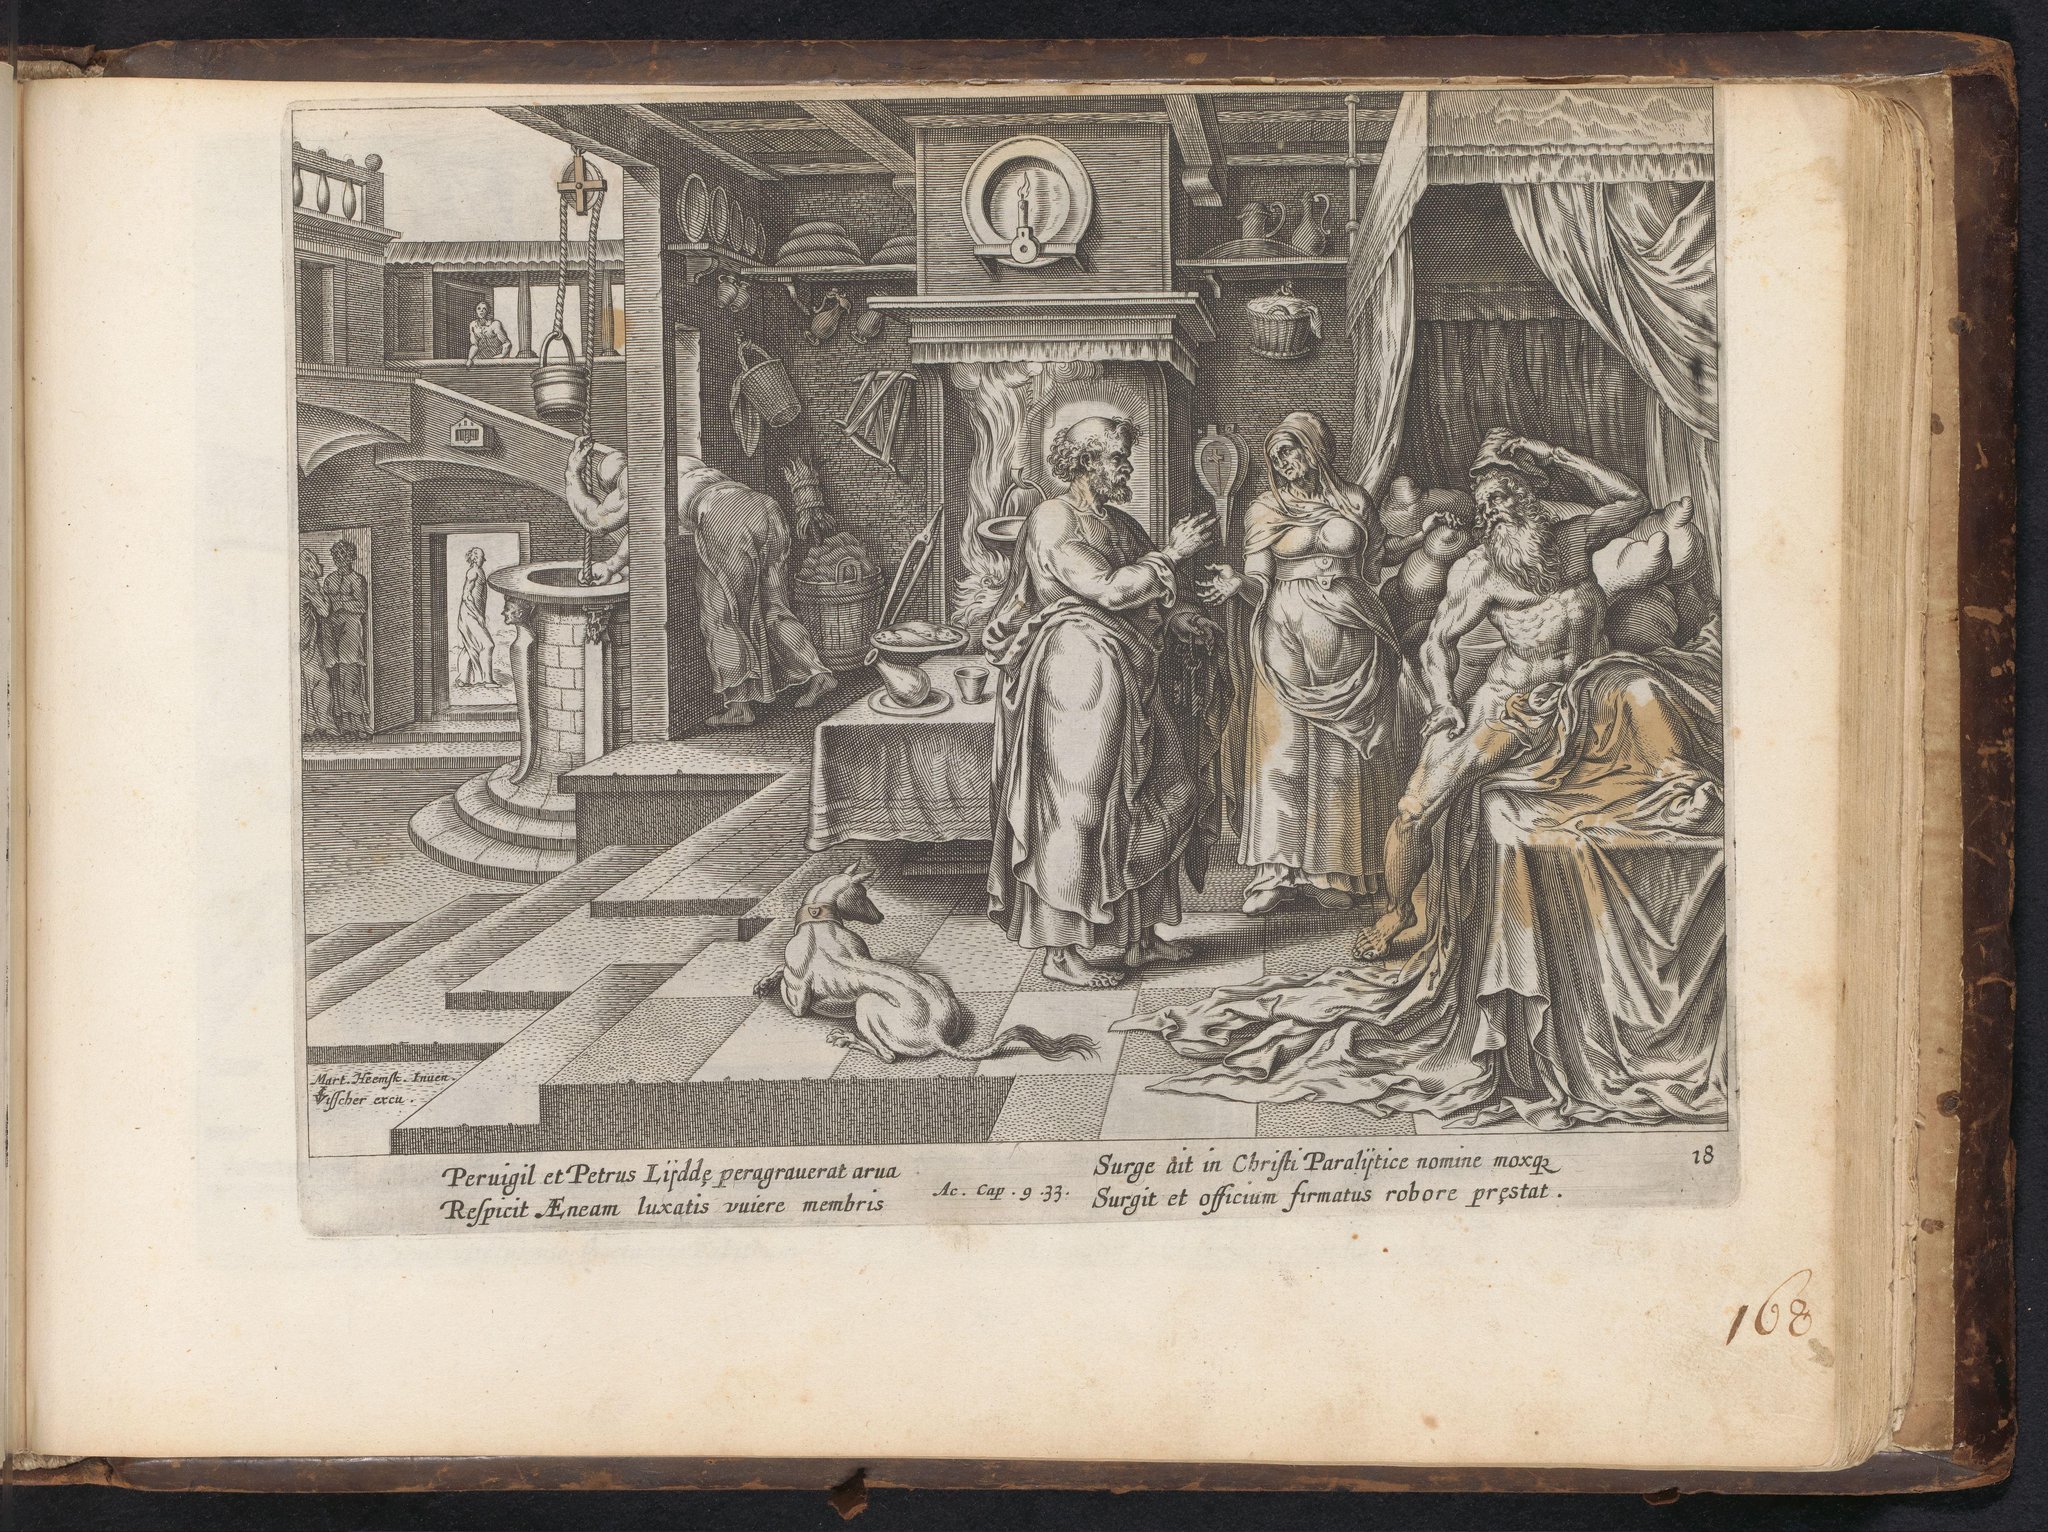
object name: print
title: Petrus geneest Eneas in Lydda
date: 1643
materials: paper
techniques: engraving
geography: alkmaar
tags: peter in lydda heals aeneas, who had been confined to his bed for eight years (acts 9:32-35)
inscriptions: number: ‘168’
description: De apostel Petrus geneest de verlamde Eneas in Lydda. Hij zegent hem en beveelt hem op te staan uit in bed. Onder de voorstelling een verwijzing in het Latijn naar de Bijbeltekst in Hand. 9:33. Deze prent maakt deel uit van een album.